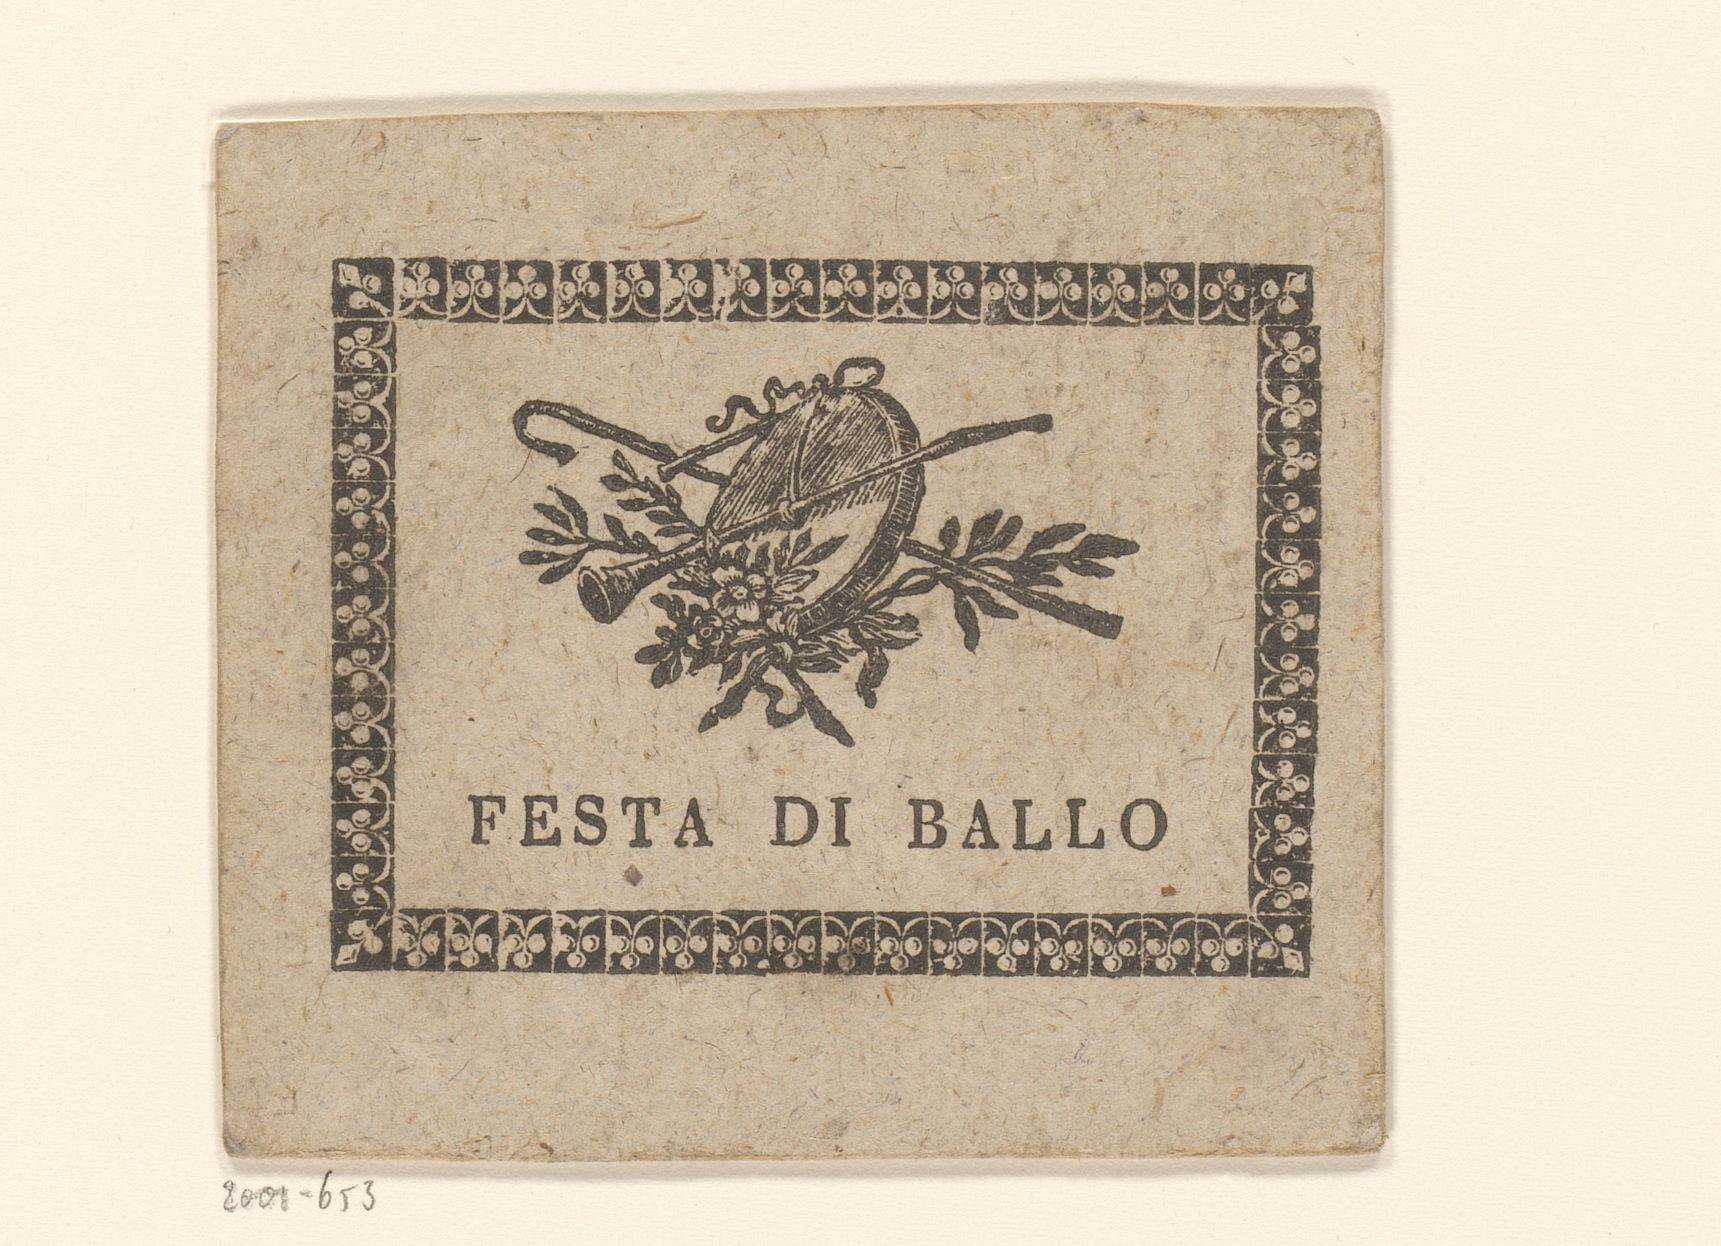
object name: print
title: Uitnodiging voor een dansfeest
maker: Anonymous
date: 1700-1799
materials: paper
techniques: letterpress printing, engraving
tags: invitation to the dance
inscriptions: collector's mark: Lugt 2760, collector's mark: Lugt 2228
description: In een decoratief kader van een herhaald klavertje drie, een trommel, herdersstaf en fluit, boven de tekst: 'Festa di ballo'.